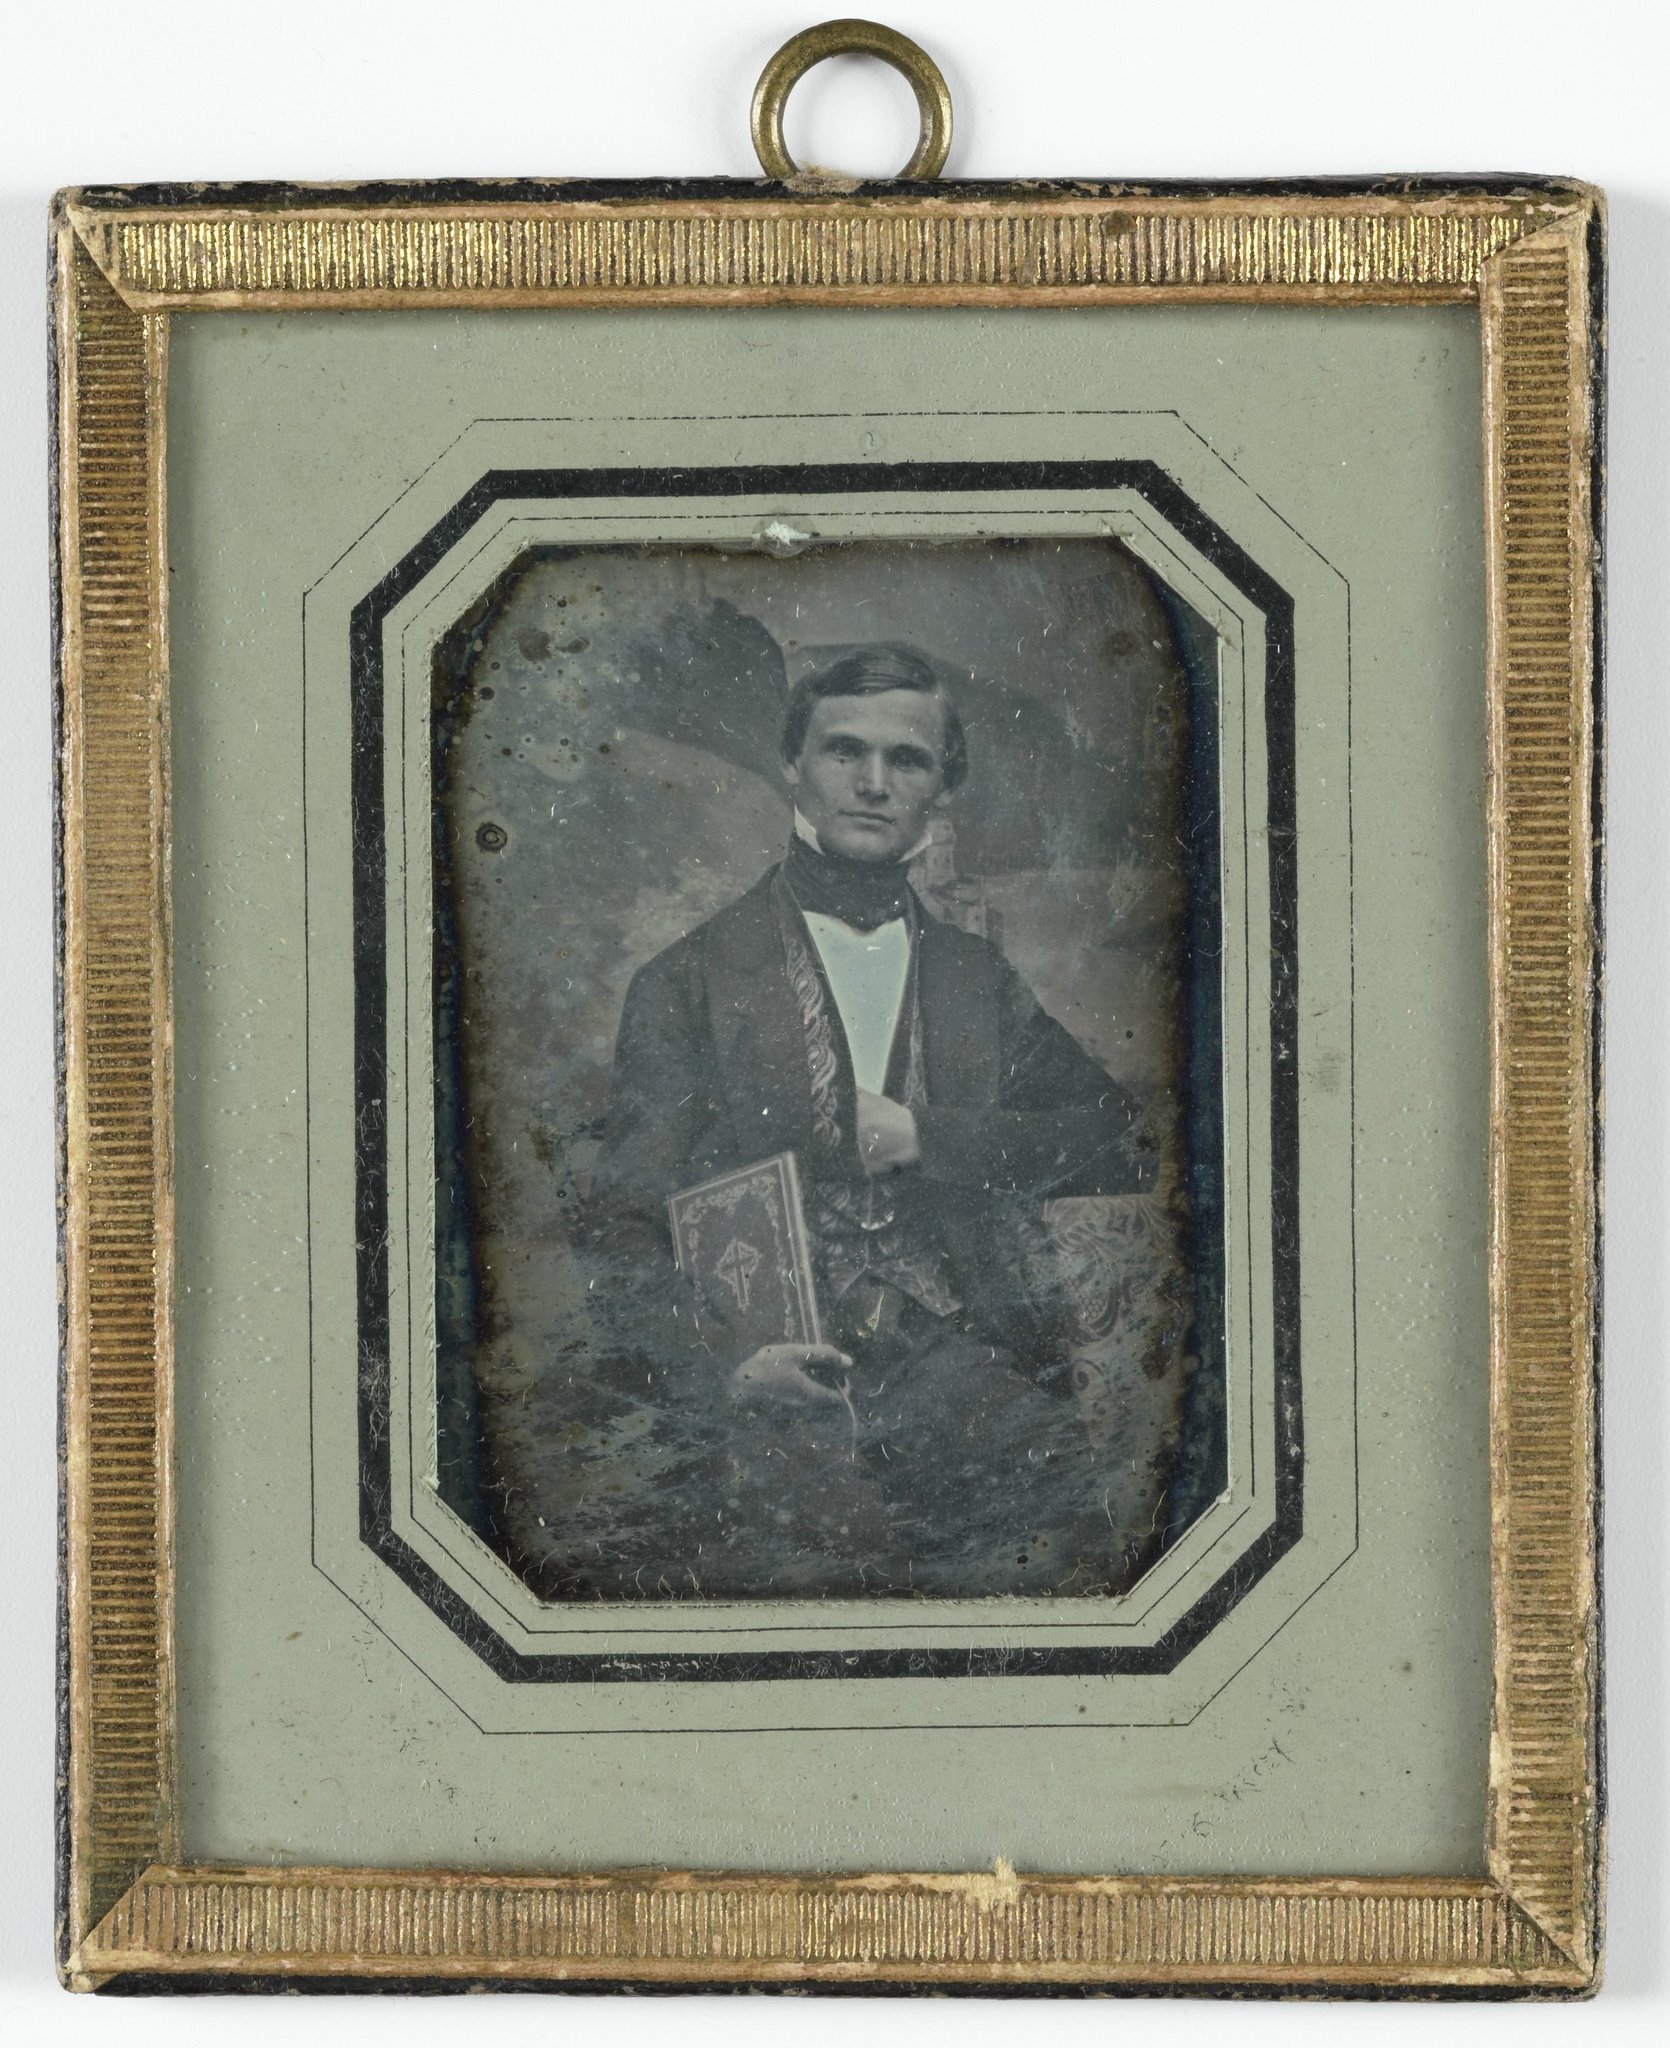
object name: photograph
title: Portret van een onbekende jonge man met bijbel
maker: Anonymous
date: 1840-1860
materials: copper, glass, paper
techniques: daguerreotype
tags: historical persons, youth, adolescent